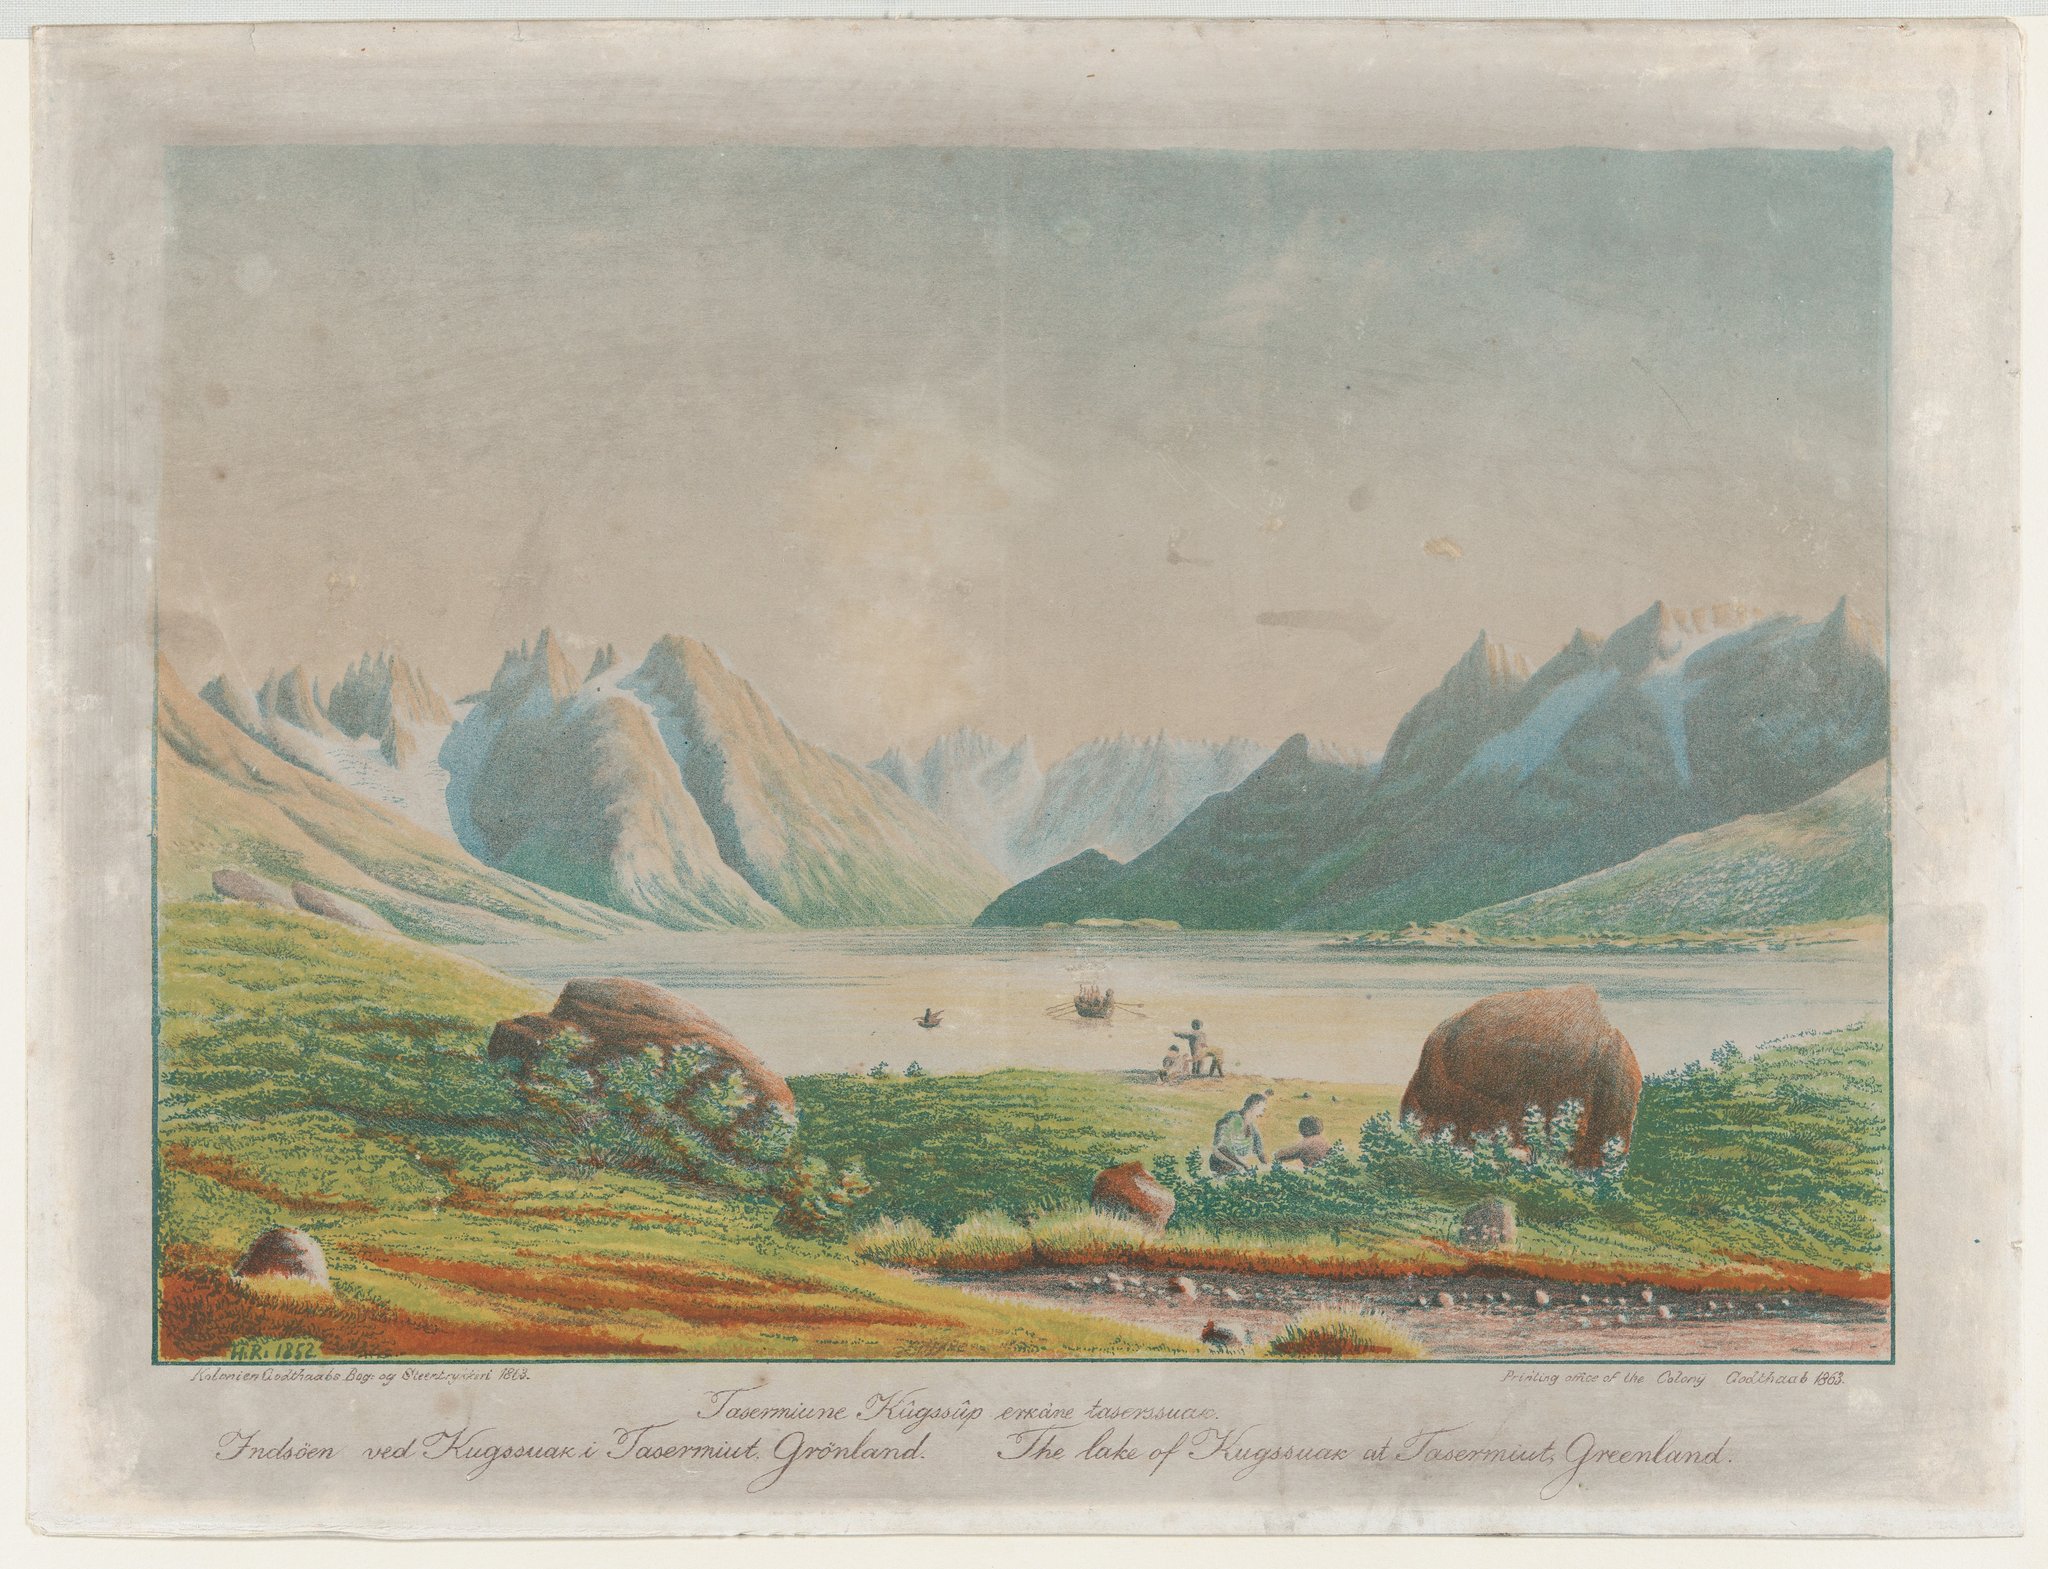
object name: print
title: The lake of Kuggsuak at Tasermiut, Greenland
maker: lars møller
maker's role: artist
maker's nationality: greenlandic-inuit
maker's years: 1842-1926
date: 1863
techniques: lithograph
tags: human figures,lakes,mountains,landscapes